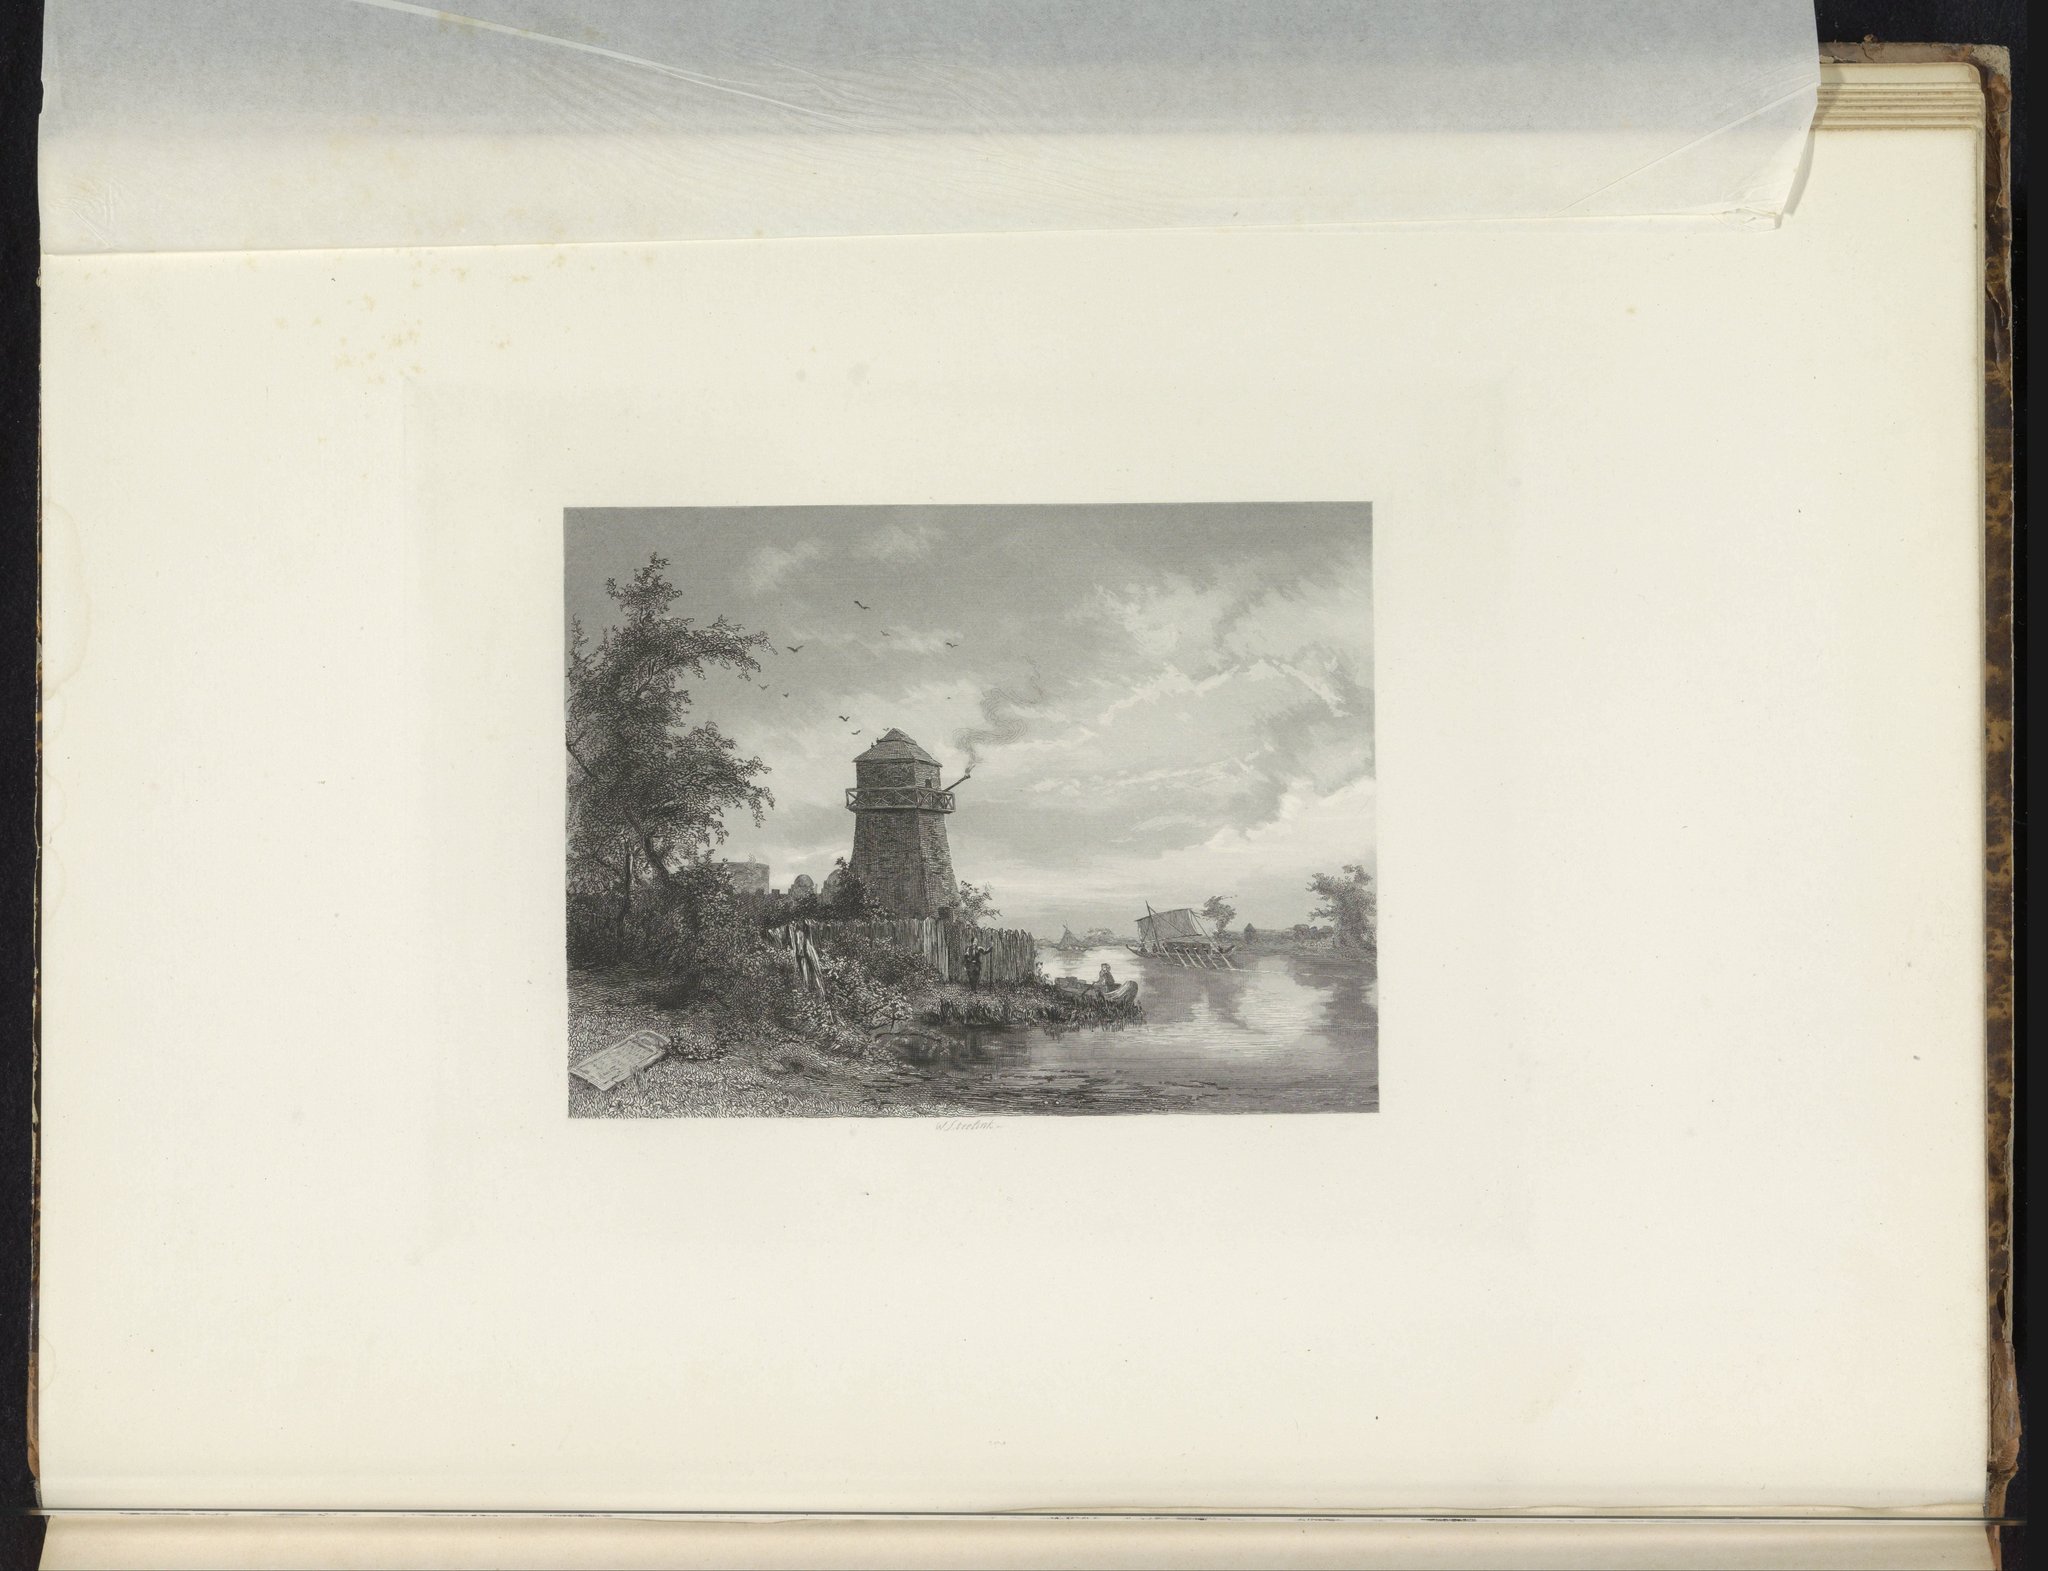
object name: history print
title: De Toltoren te Utrecht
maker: willem steelink (i)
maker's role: draughtsman, print maker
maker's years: 1826-1913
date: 1865-1870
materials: paper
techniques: engraving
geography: netherlands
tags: toll gate, utrecht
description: Toltoren te Utrecht tijdens de Romeinse tijd in Nederland. Op het water een galei. Onderdeel van de groep staalgravures naar de schilderijen van de Historische Galerij der Maatschappij Arti et Amicitiae.